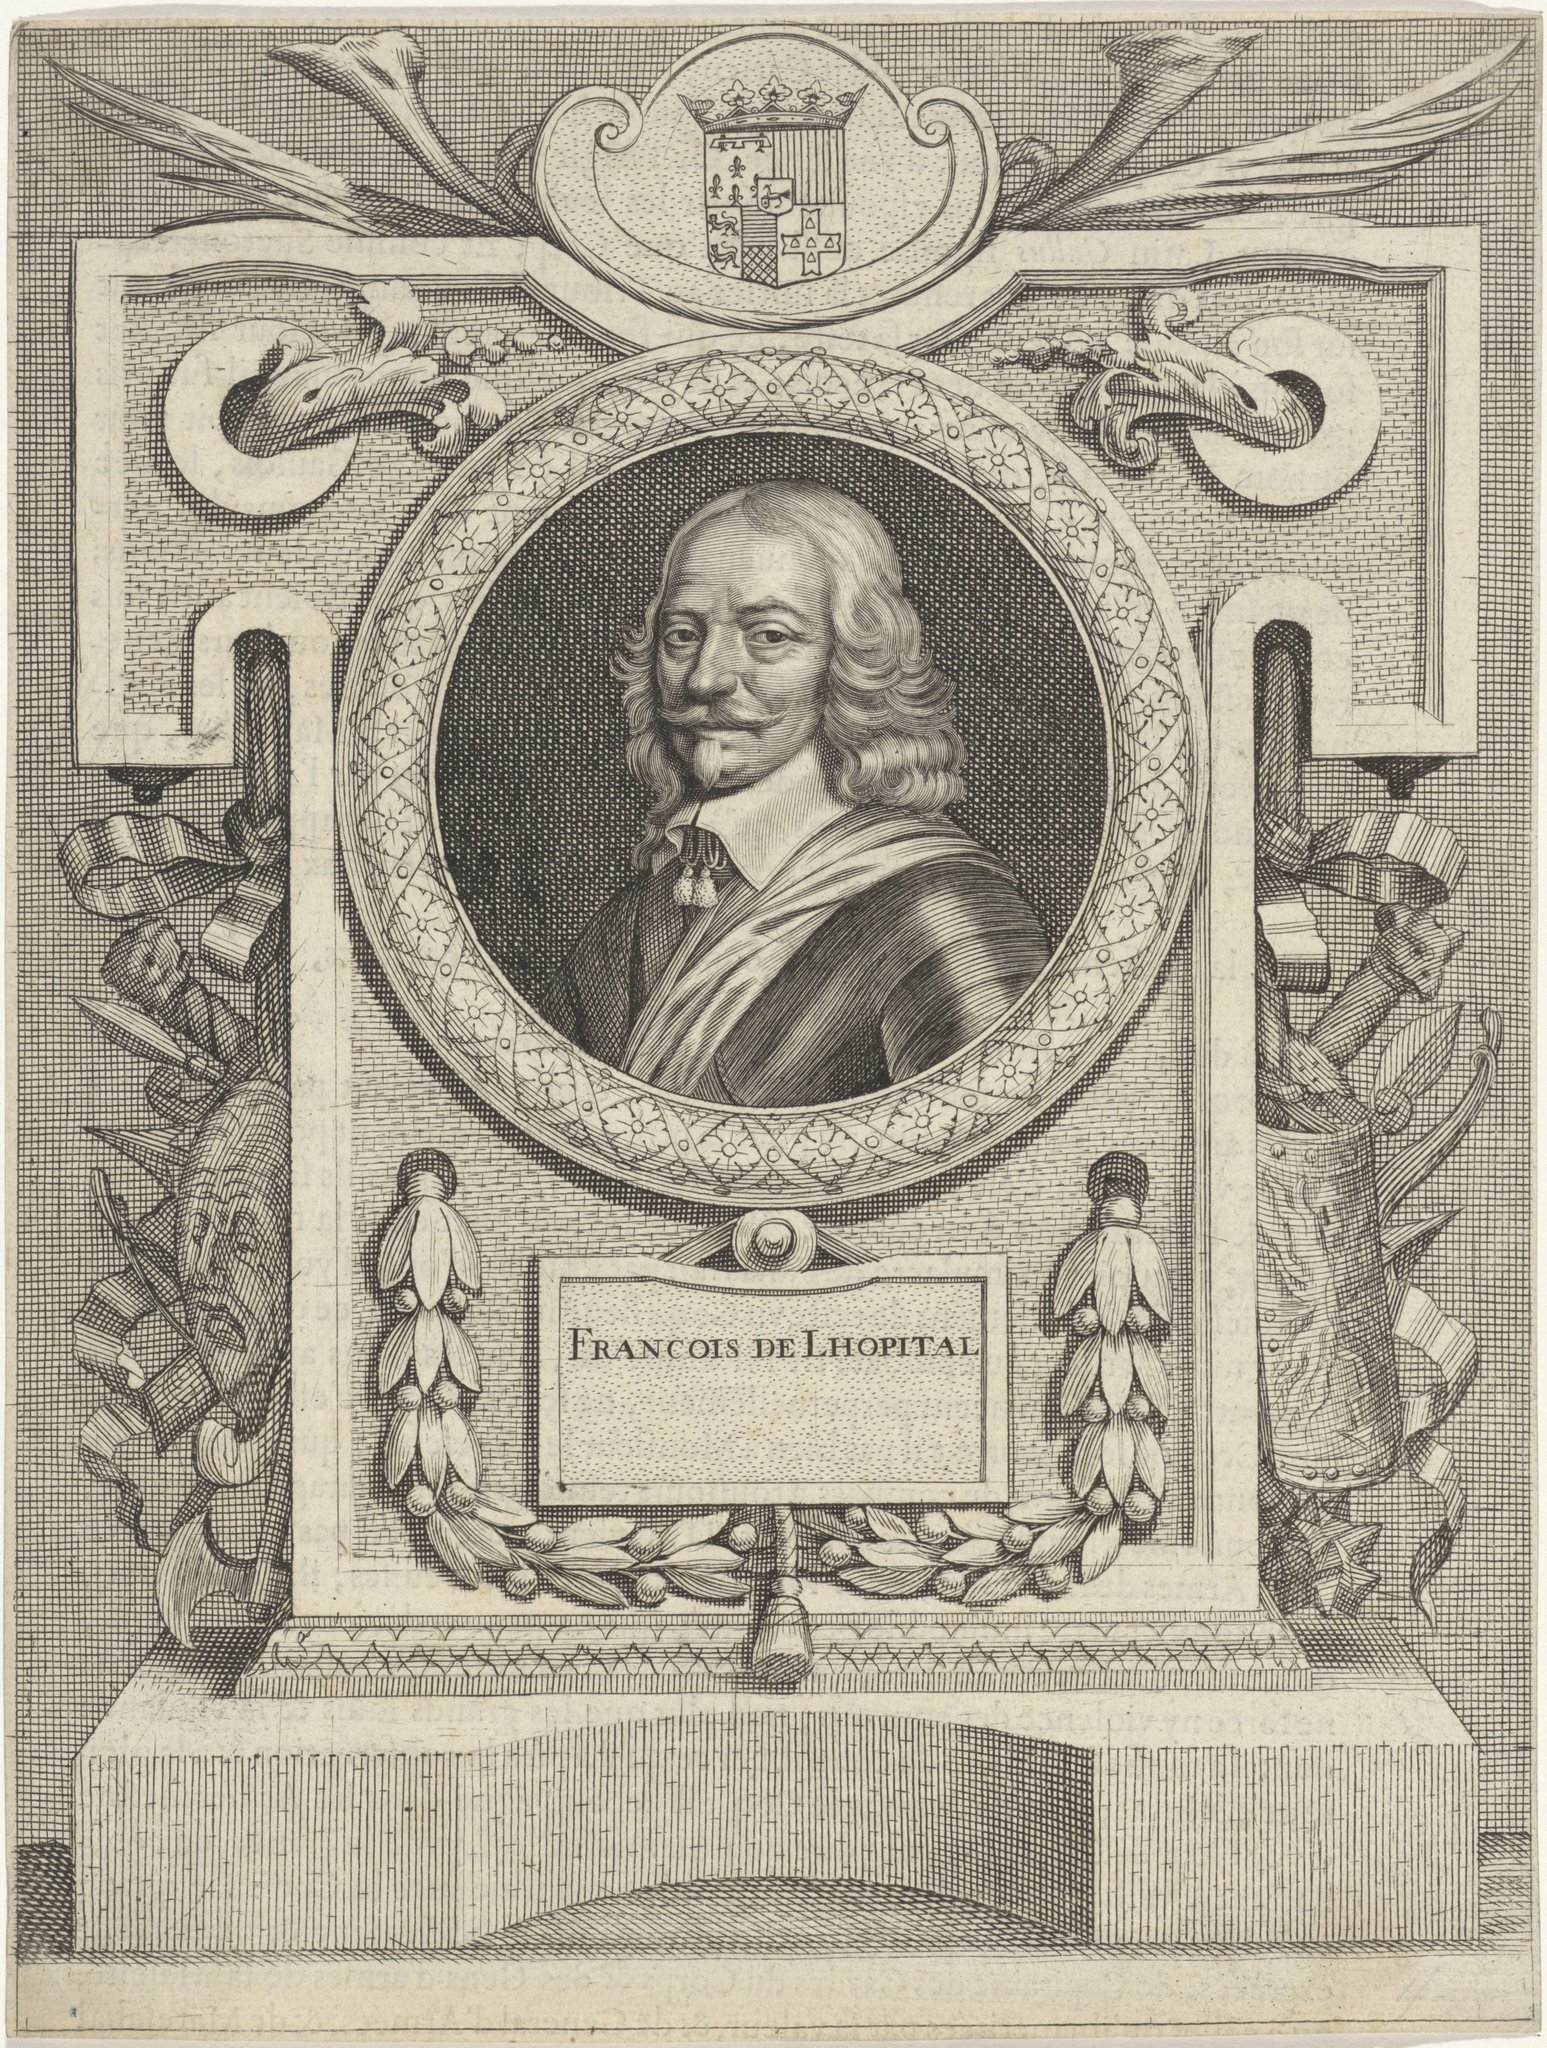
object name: print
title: Portretten van koningen, prinsen en generaals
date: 1649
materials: paper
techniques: engraving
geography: paris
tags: lodewijk xiii (koning van frankrijk)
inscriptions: collector's mark: Lugt 2228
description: Boekillustratie in: Estienne, Henry. Devises des roys, princes et generaux d'armees qui ont assiste ou servy Louis le Juste combattant. In: Les Triomphes de Louis le Juste XIII. Parijs: A. Estienne, 1649.